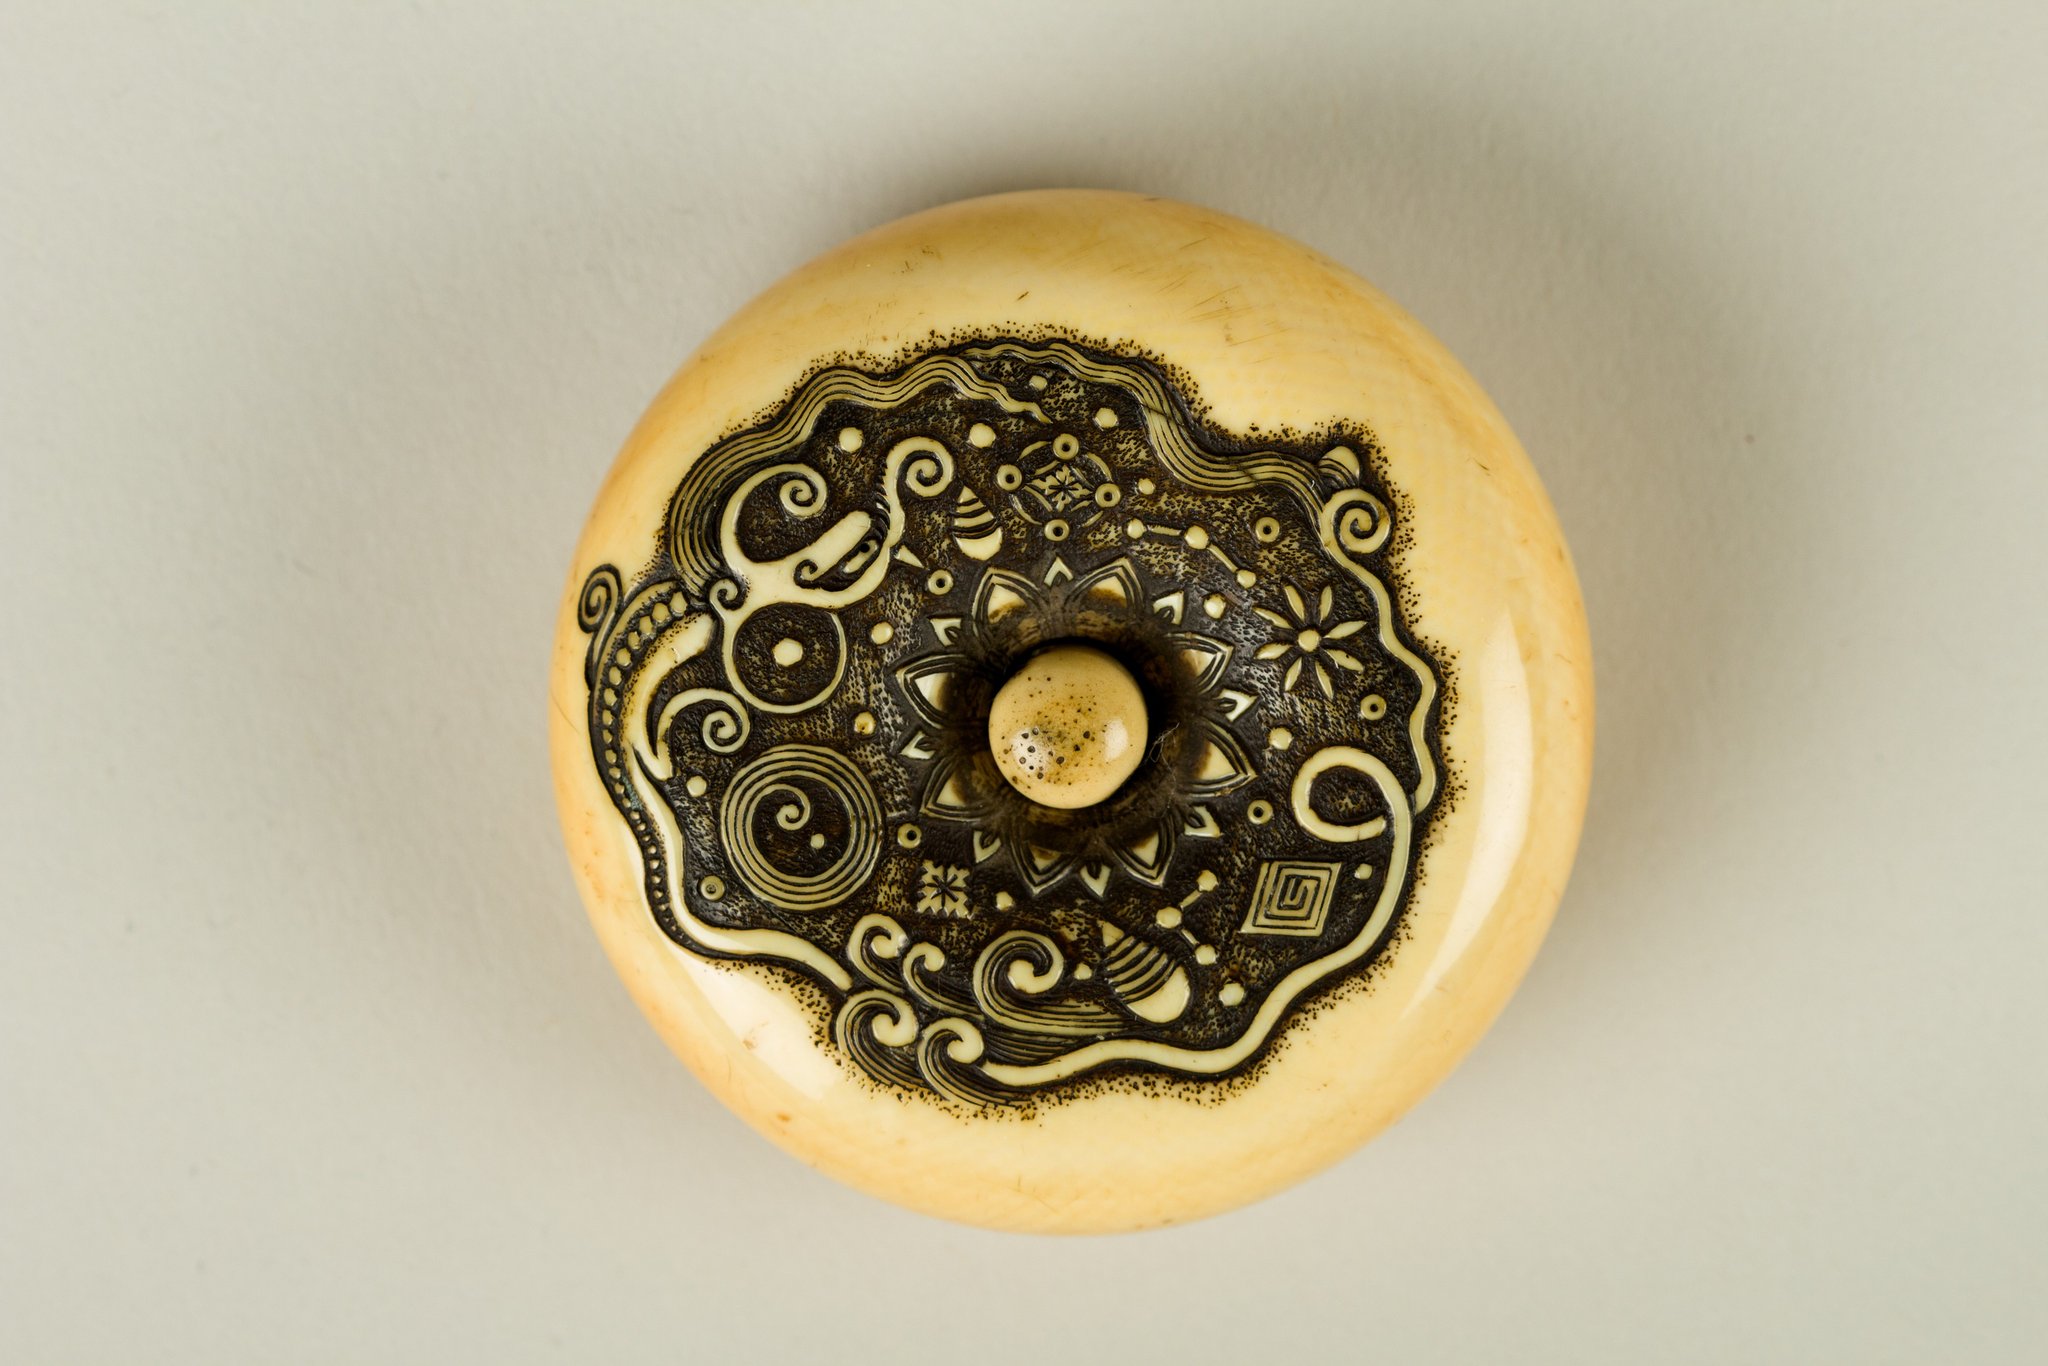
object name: netsuke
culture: japanese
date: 1801-1900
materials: ivory